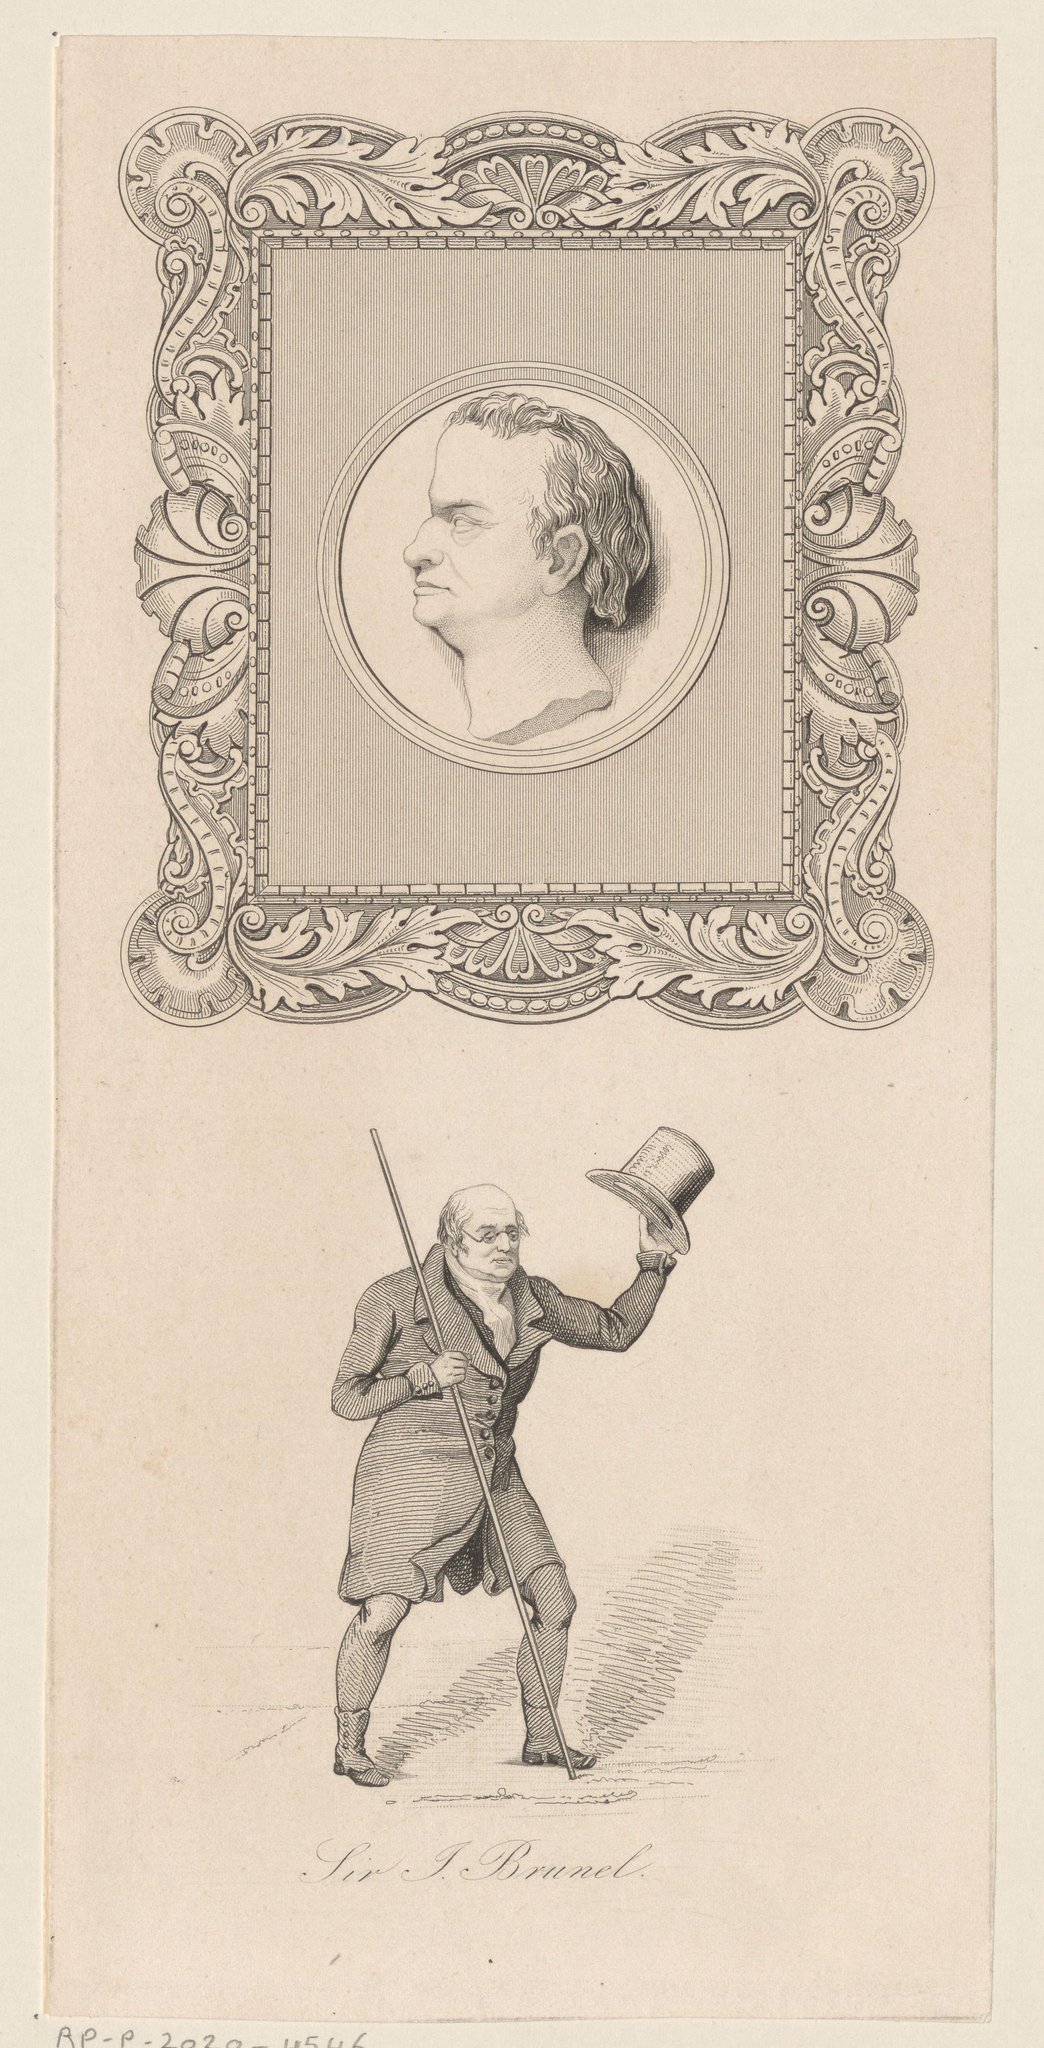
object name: print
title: Portretten van Marc Isambard Brunel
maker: Anonymous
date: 1825-1899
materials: paper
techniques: etching, roulette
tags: london, historical persons